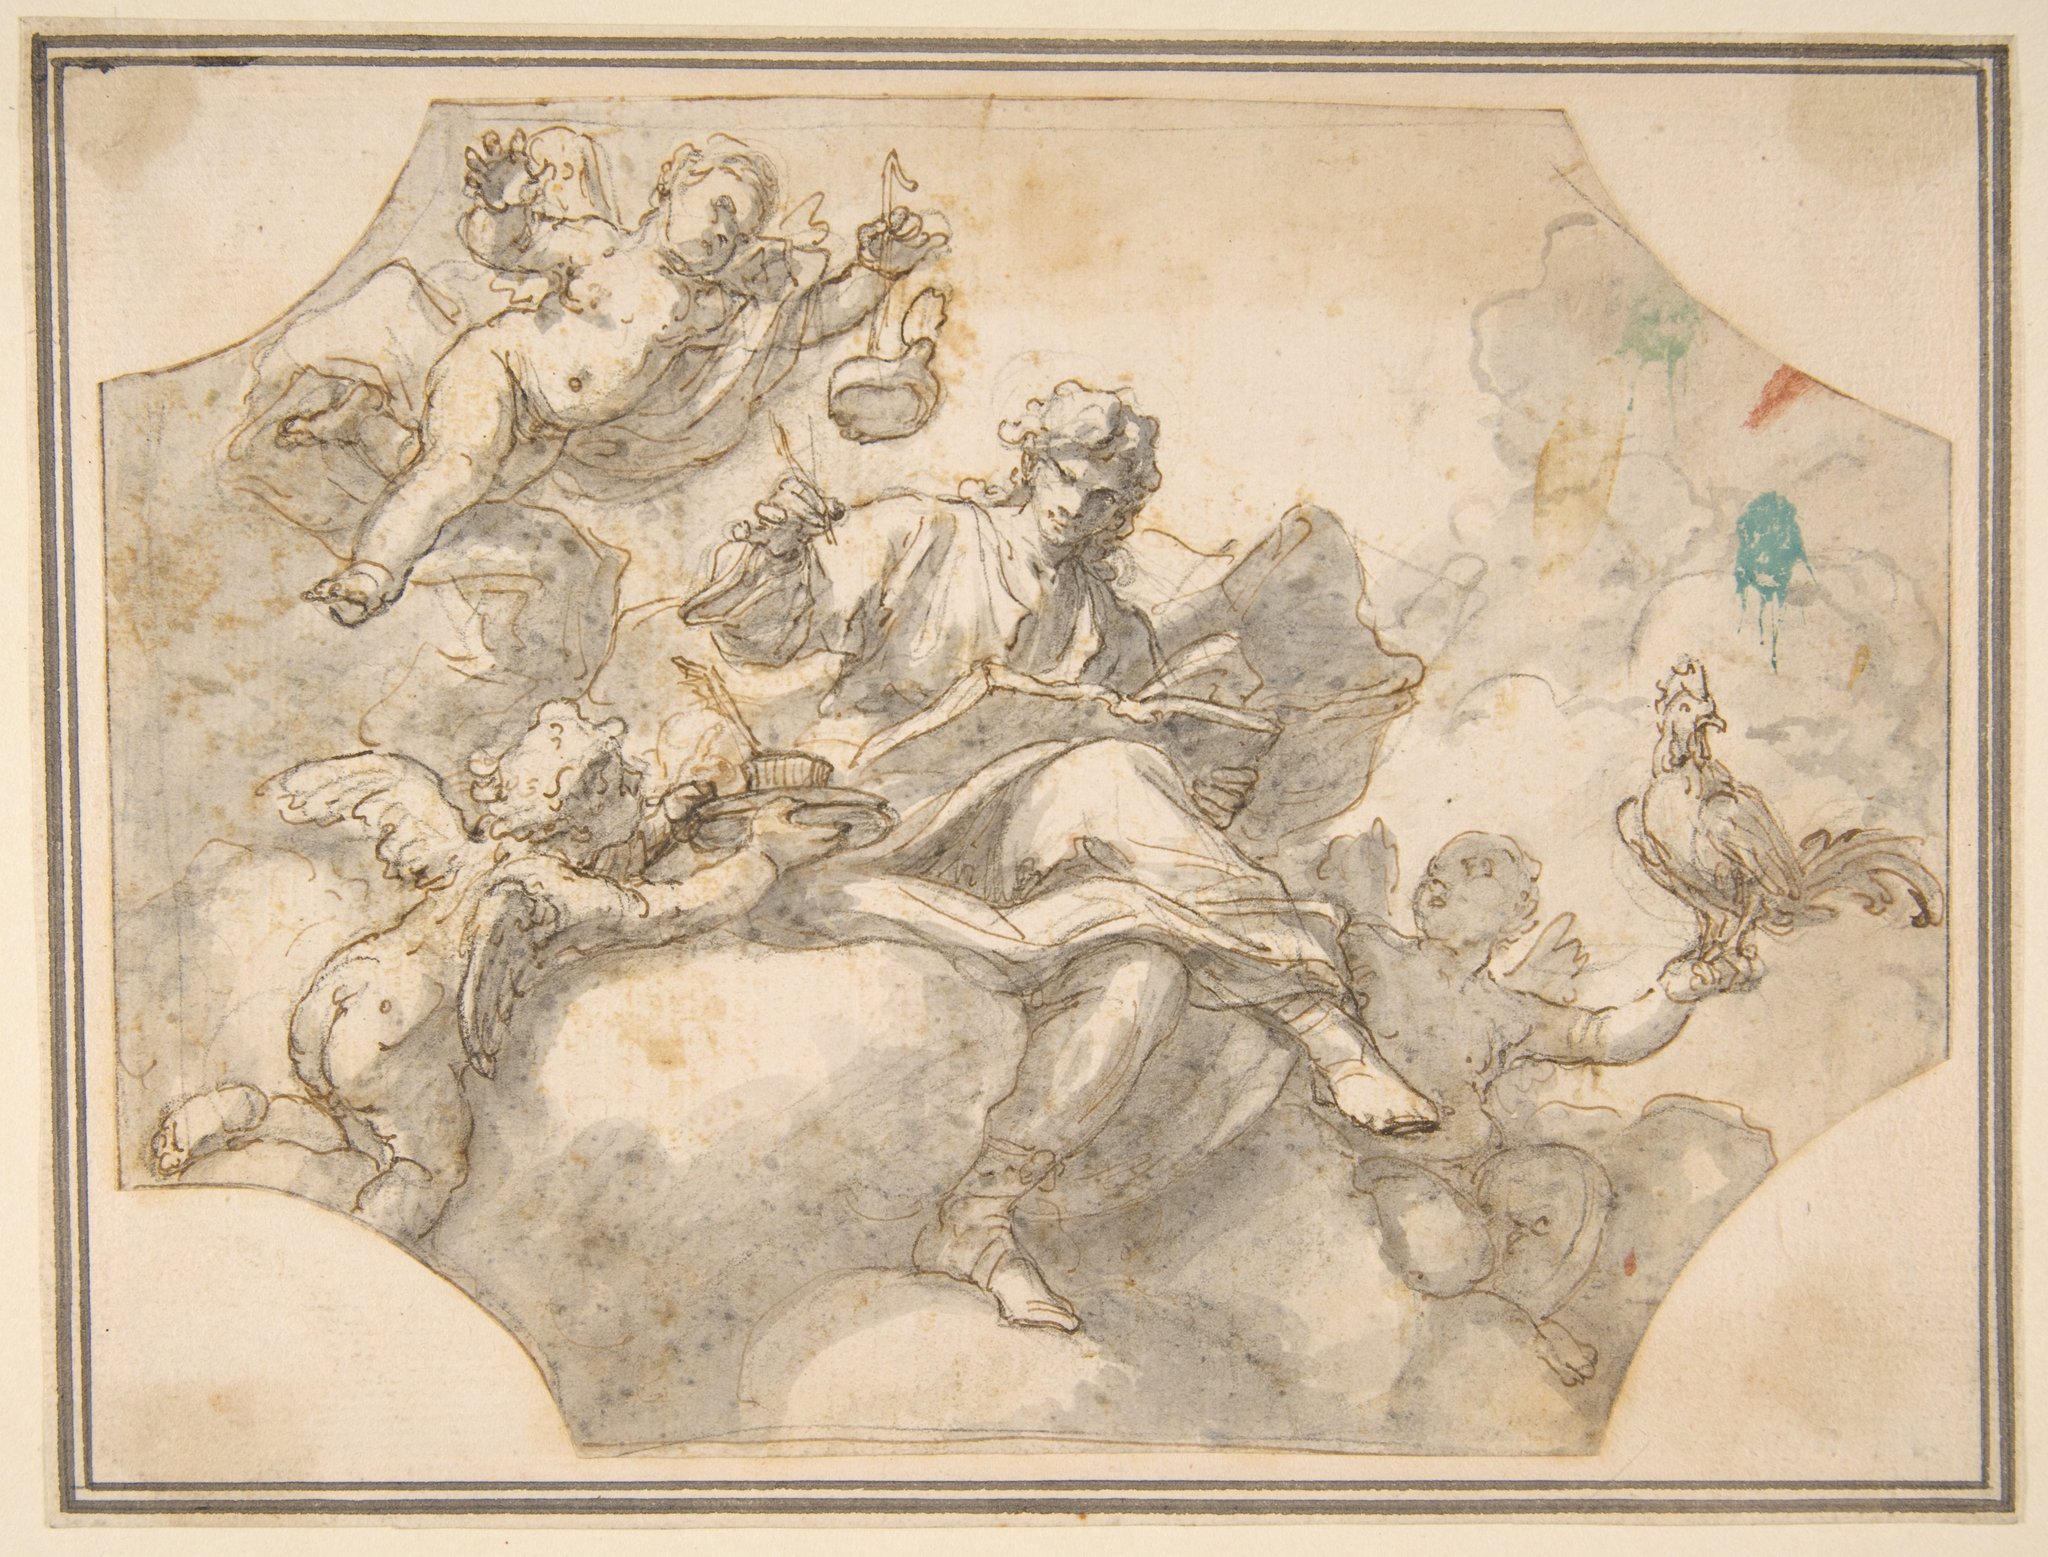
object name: drawing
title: Allegorical Figure of Study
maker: francesco solimena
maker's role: artist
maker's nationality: italian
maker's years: 1657-1747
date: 1657-1747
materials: chalk, ink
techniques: brush, pen, wash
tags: men,putti,roosters,writing